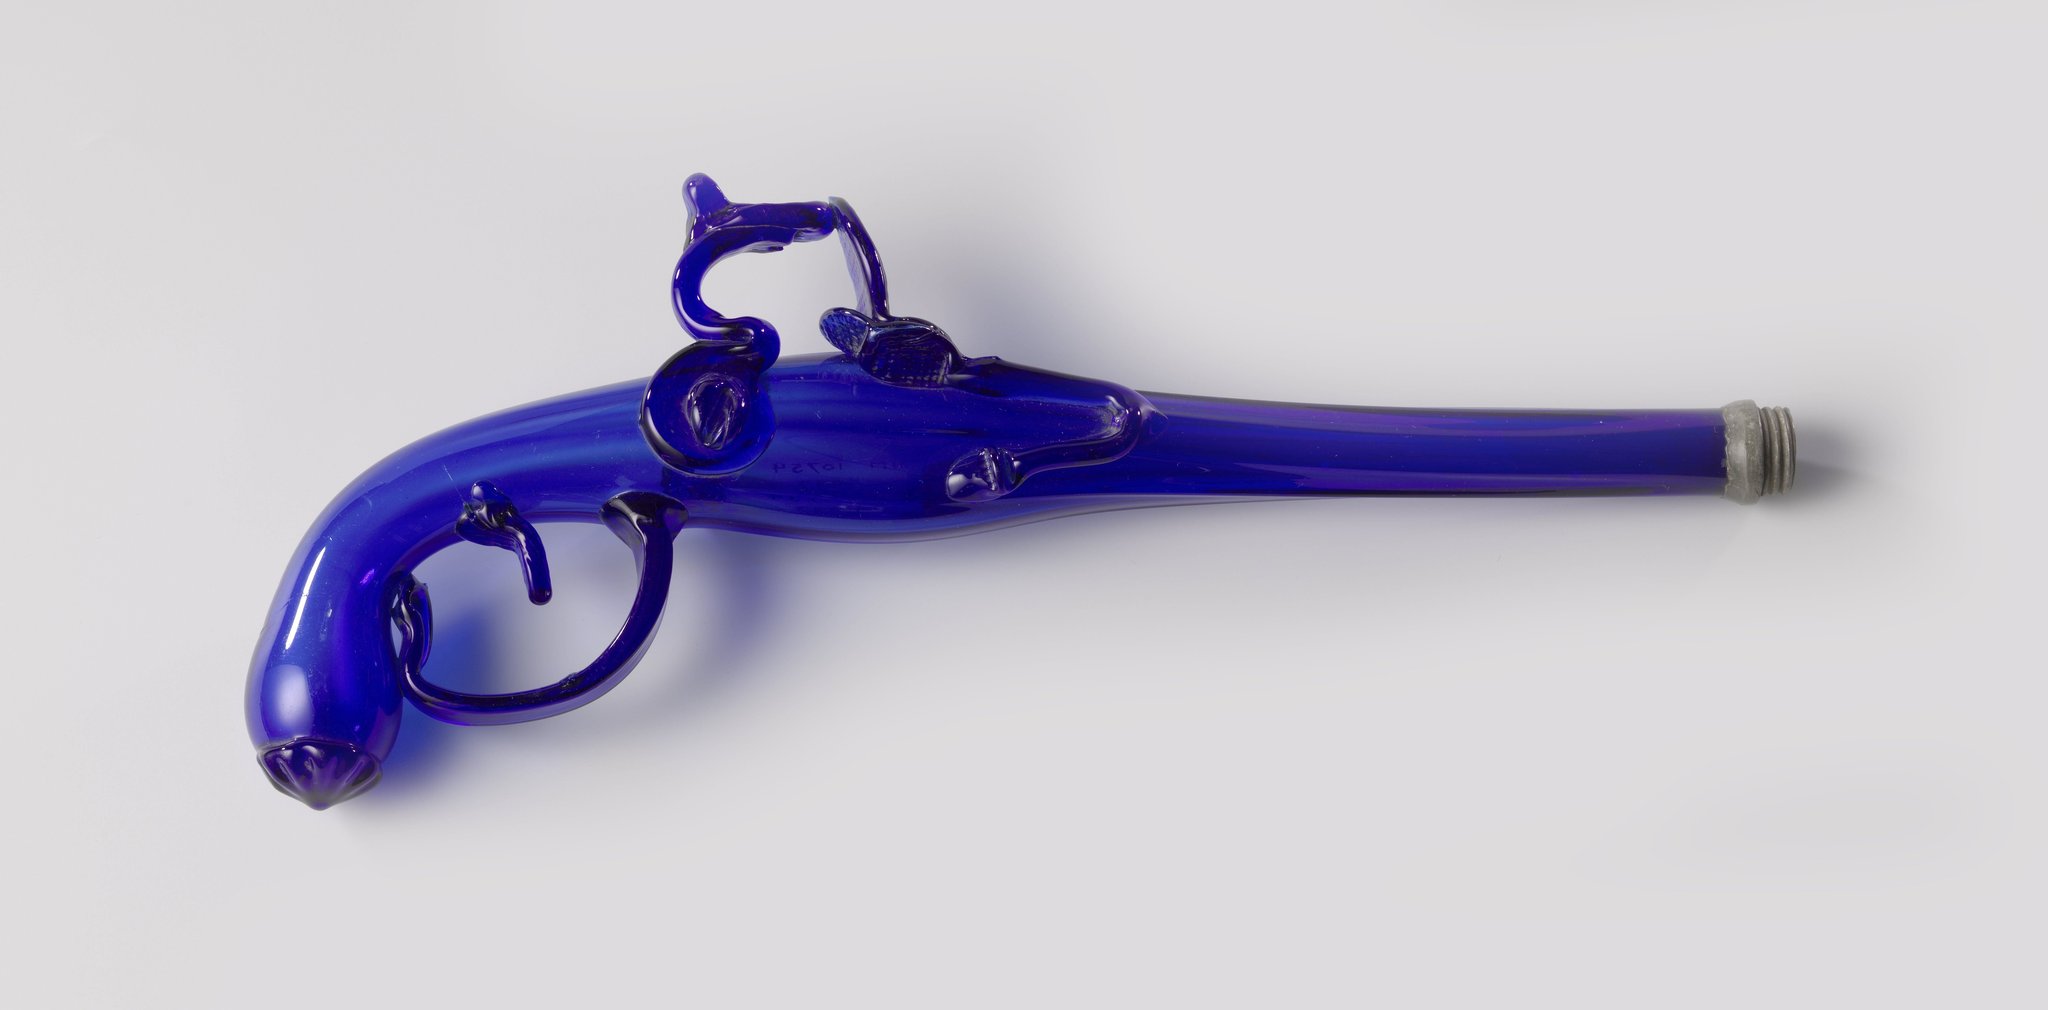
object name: pistoolfles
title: Glas in vorm van een pistool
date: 1650-1700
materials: glass, tin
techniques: glassblowing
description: Kolf en loop geblazen uit een flauw geribde, blauwe buis. Aan de onderzijde een rozetvormige kolfknop. De opgesmolten delen -radslot, slotplaat, trekker en beugel - zijn massief. De monding van de loop is afgewerkt met een tinnen schroefdraadmontuur.